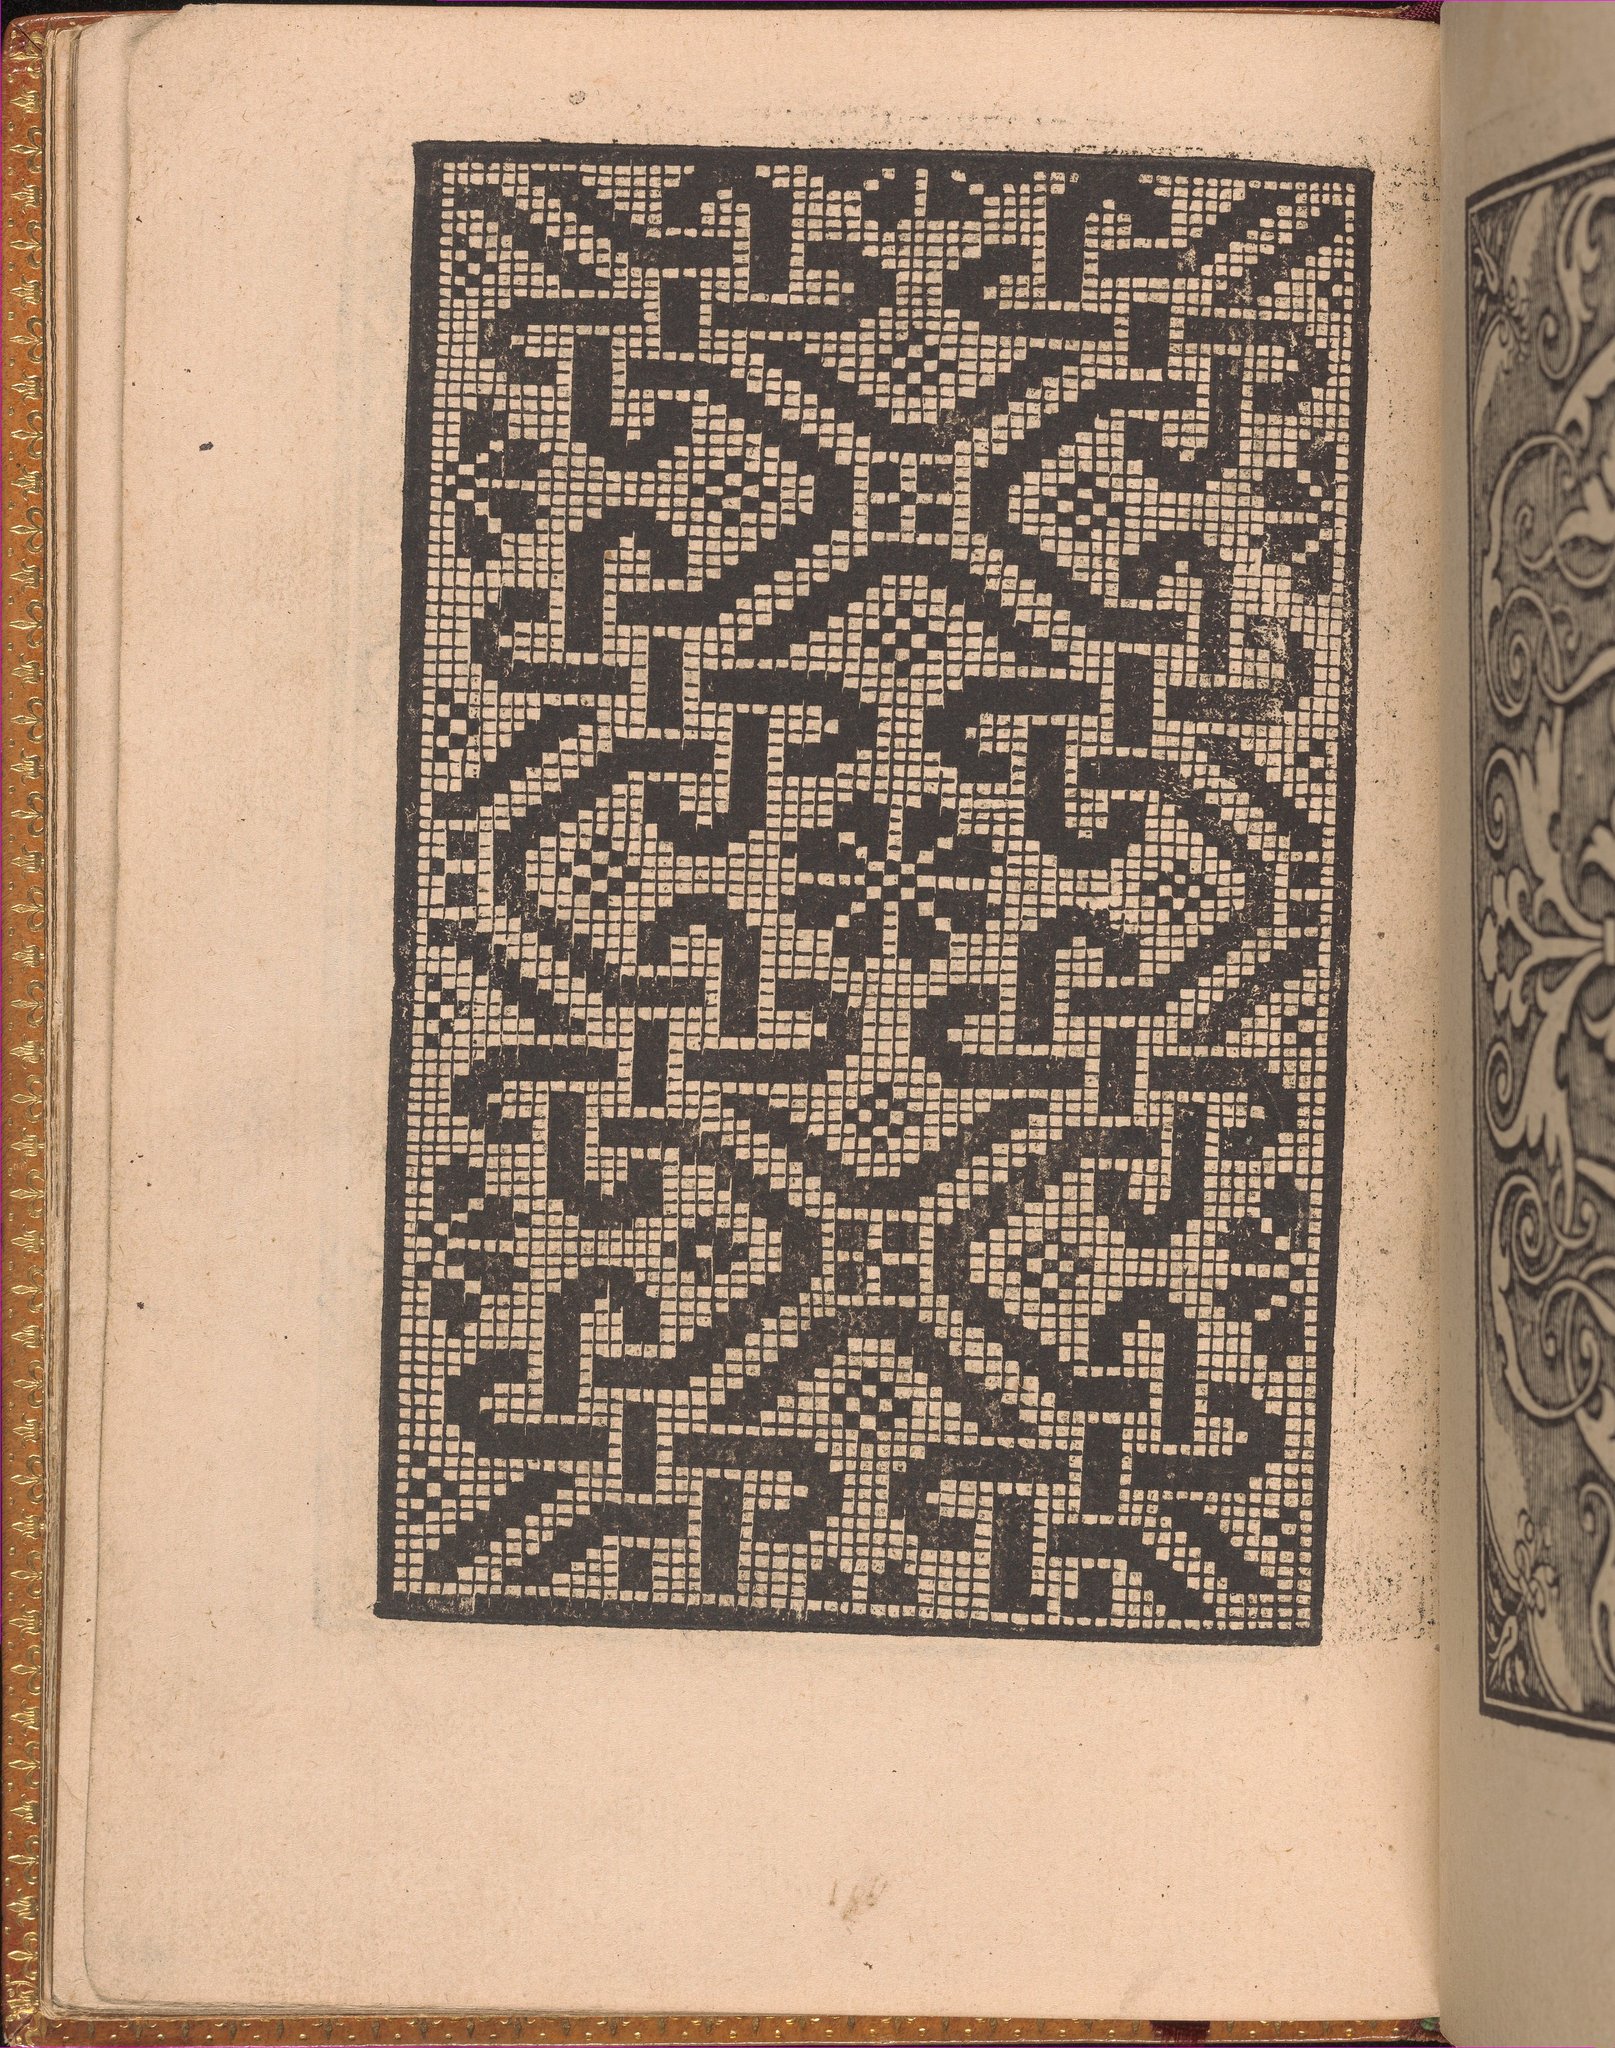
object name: book print ornament architecture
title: Convivio delle Belle Donne, page 20 (verso)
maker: nicolò zoppino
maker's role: publisher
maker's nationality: italian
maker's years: 1478-1544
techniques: woodcut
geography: italy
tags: ornament